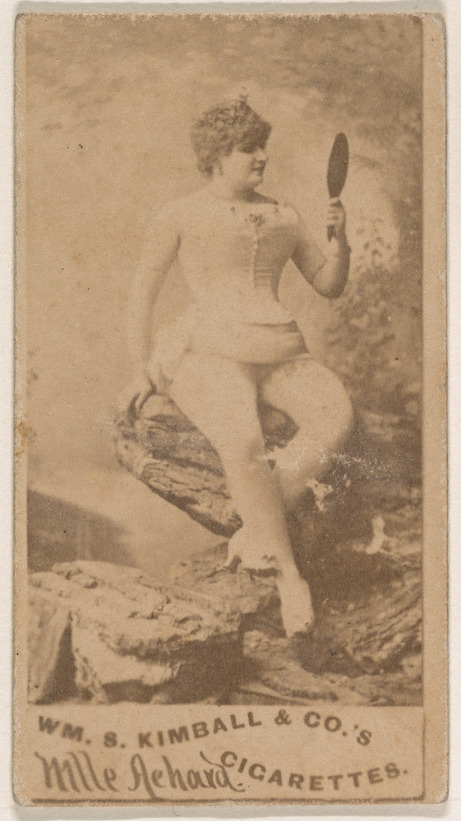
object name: photograph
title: Mlle. Aehard, from the Actresses series (N203) issued by Wm. S. Kimball & Co.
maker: william s. kimball & company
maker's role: publisher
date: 1889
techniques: color lithograph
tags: portraits,women,actresses